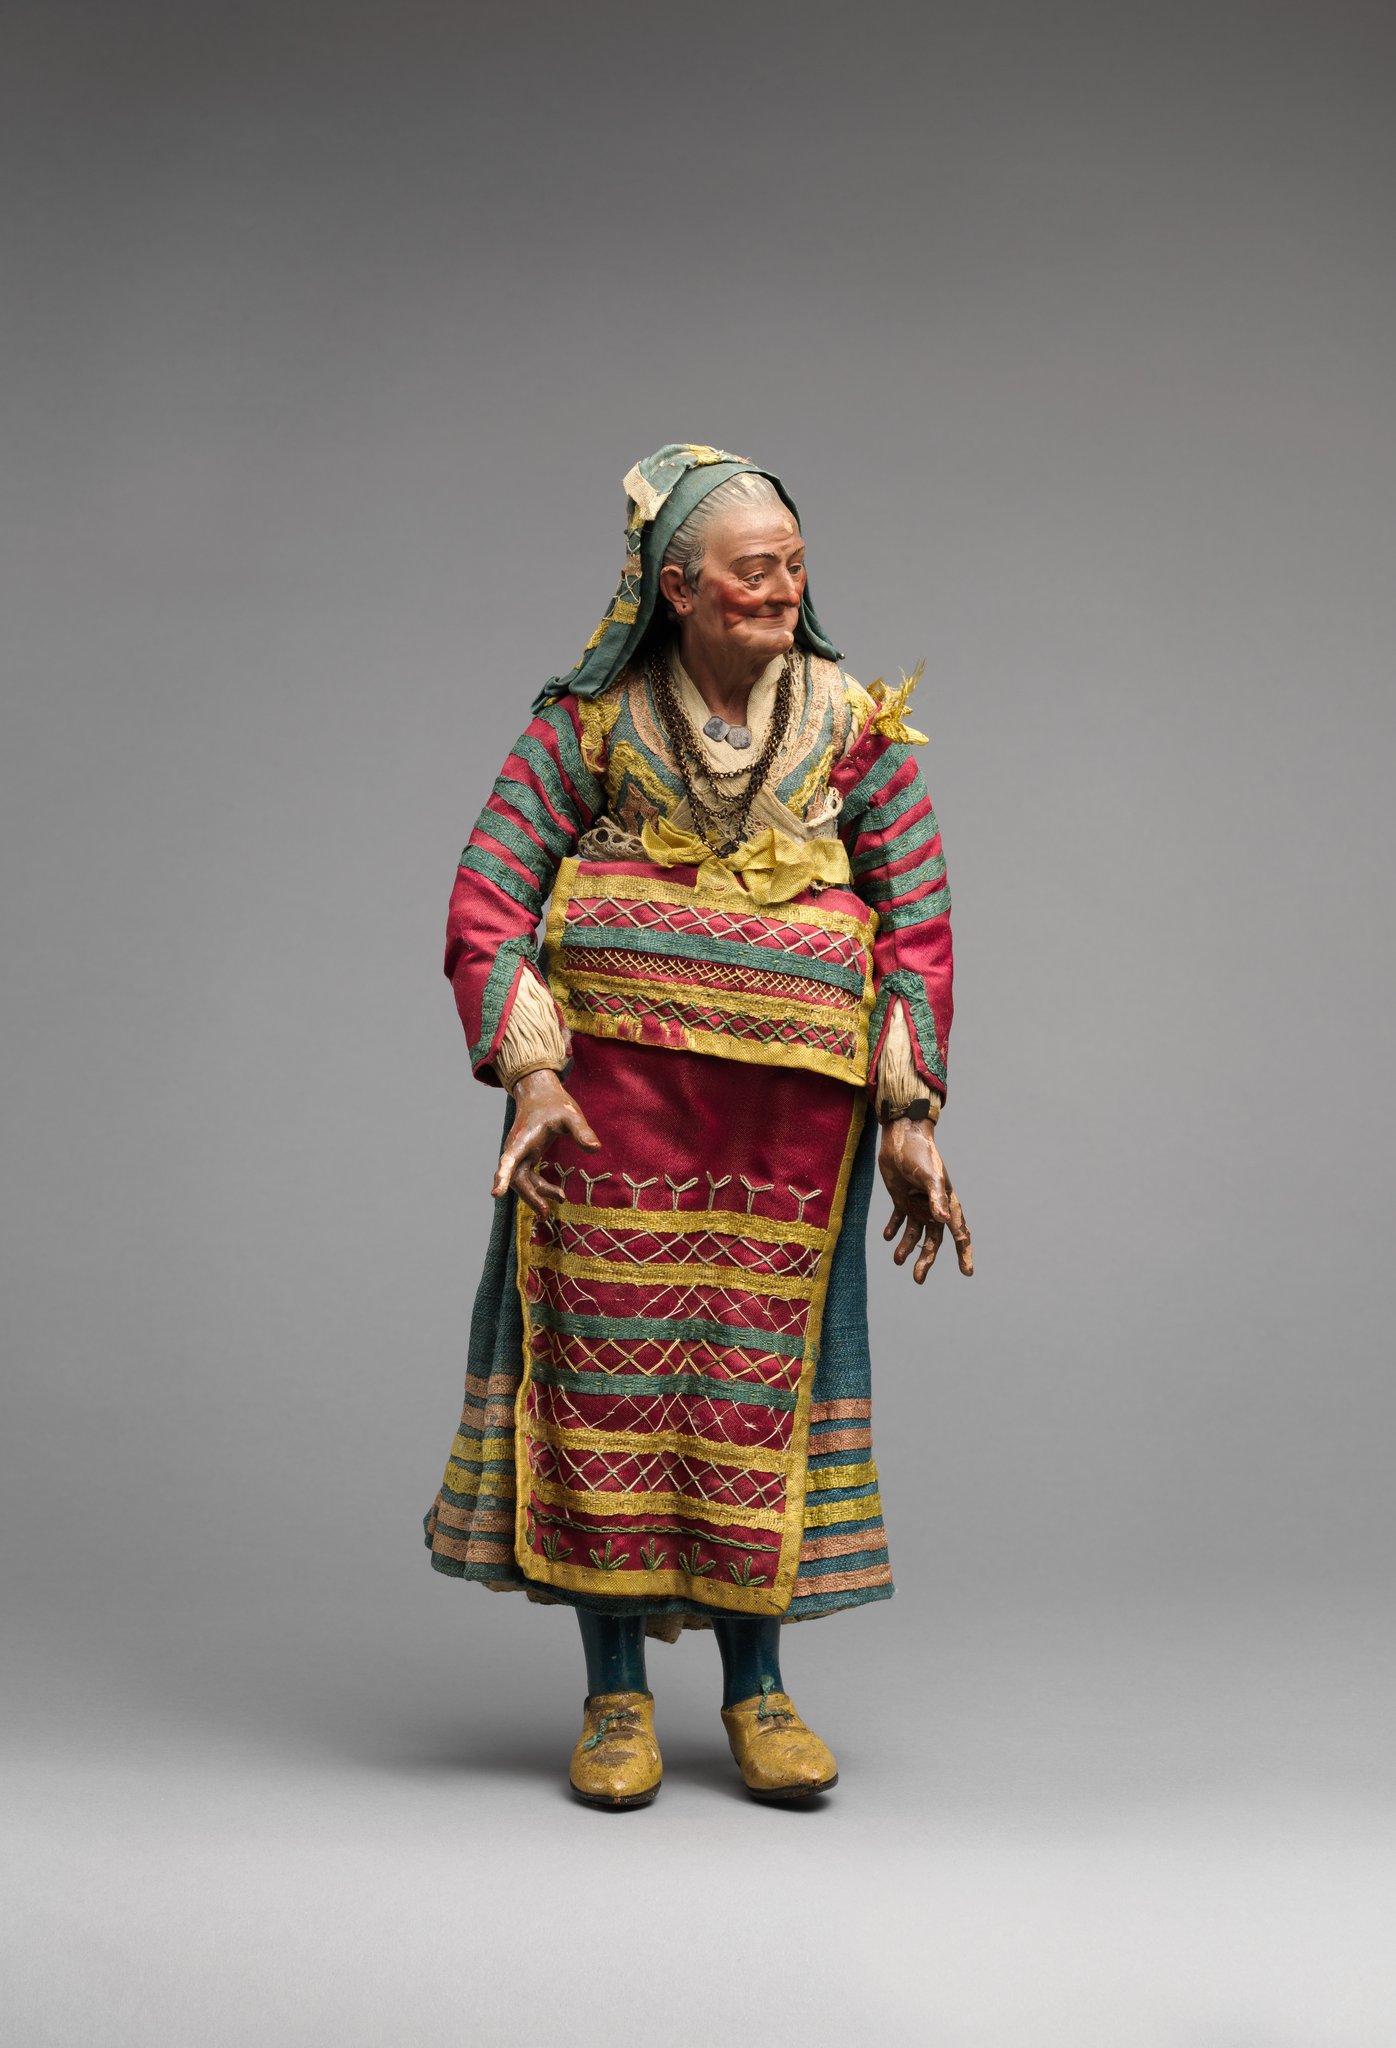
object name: crèche figure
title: Old woman in blue dress and various color apron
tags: women